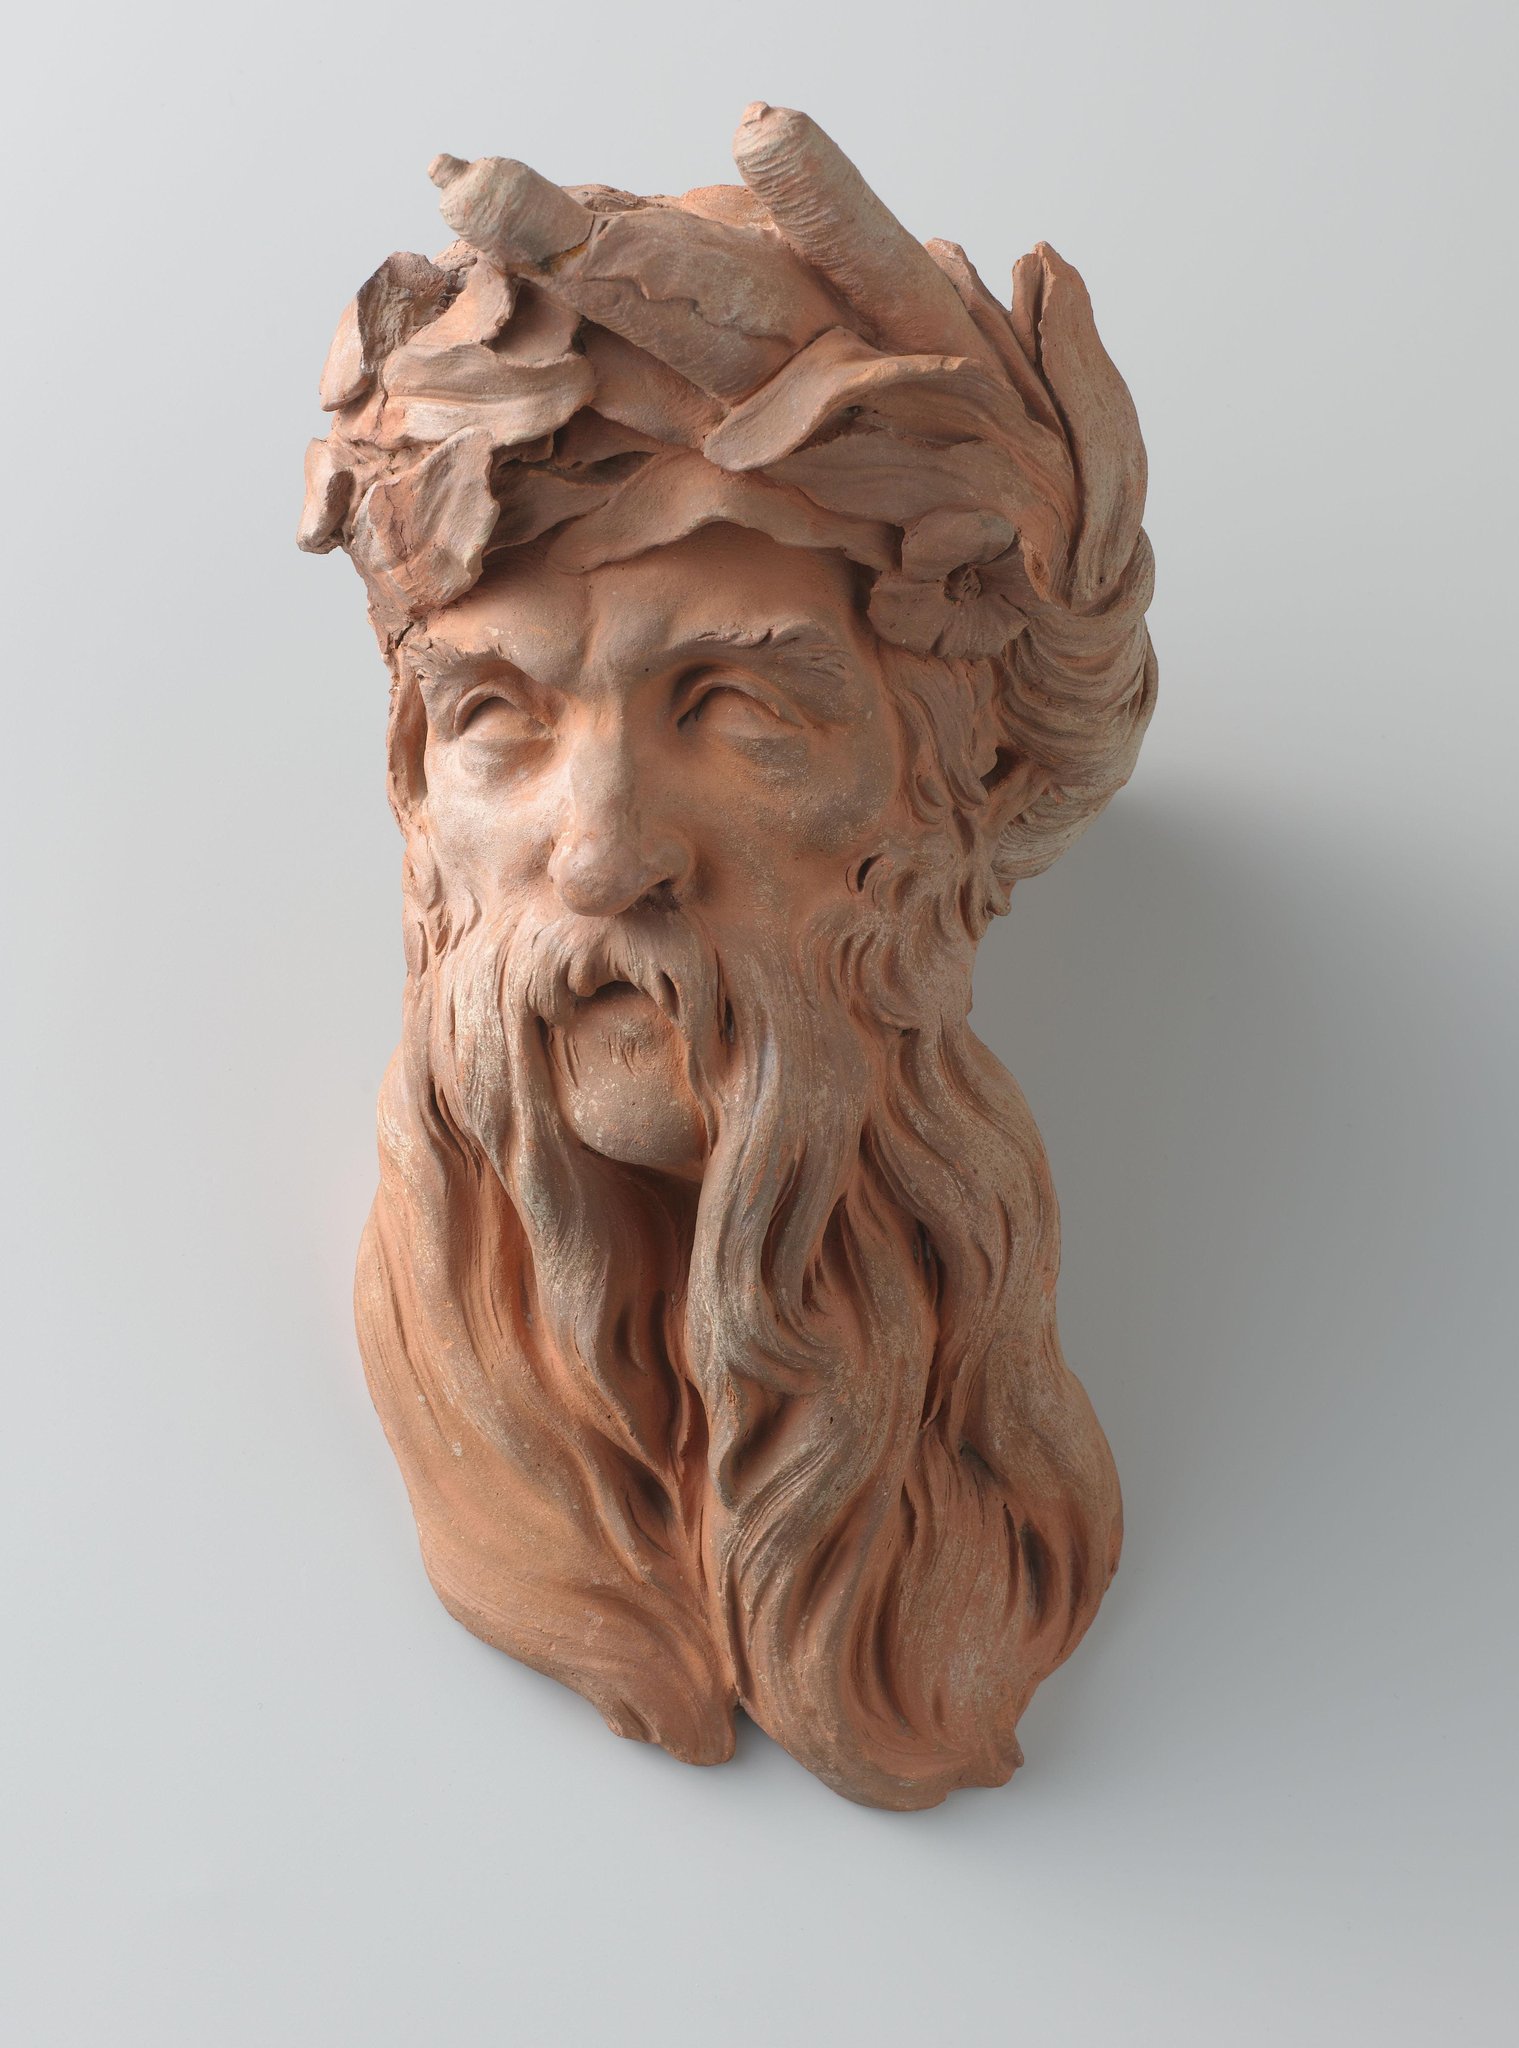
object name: sculpture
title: Kop van een riviergod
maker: artus quellinus (i)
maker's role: draughtsman, print maker, sculptor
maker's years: 1609-1668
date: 1650-1655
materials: terracotta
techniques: modeling